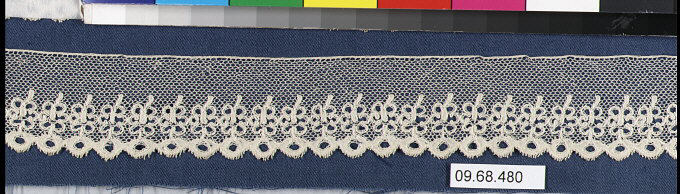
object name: fragment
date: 1801-1900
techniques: lace